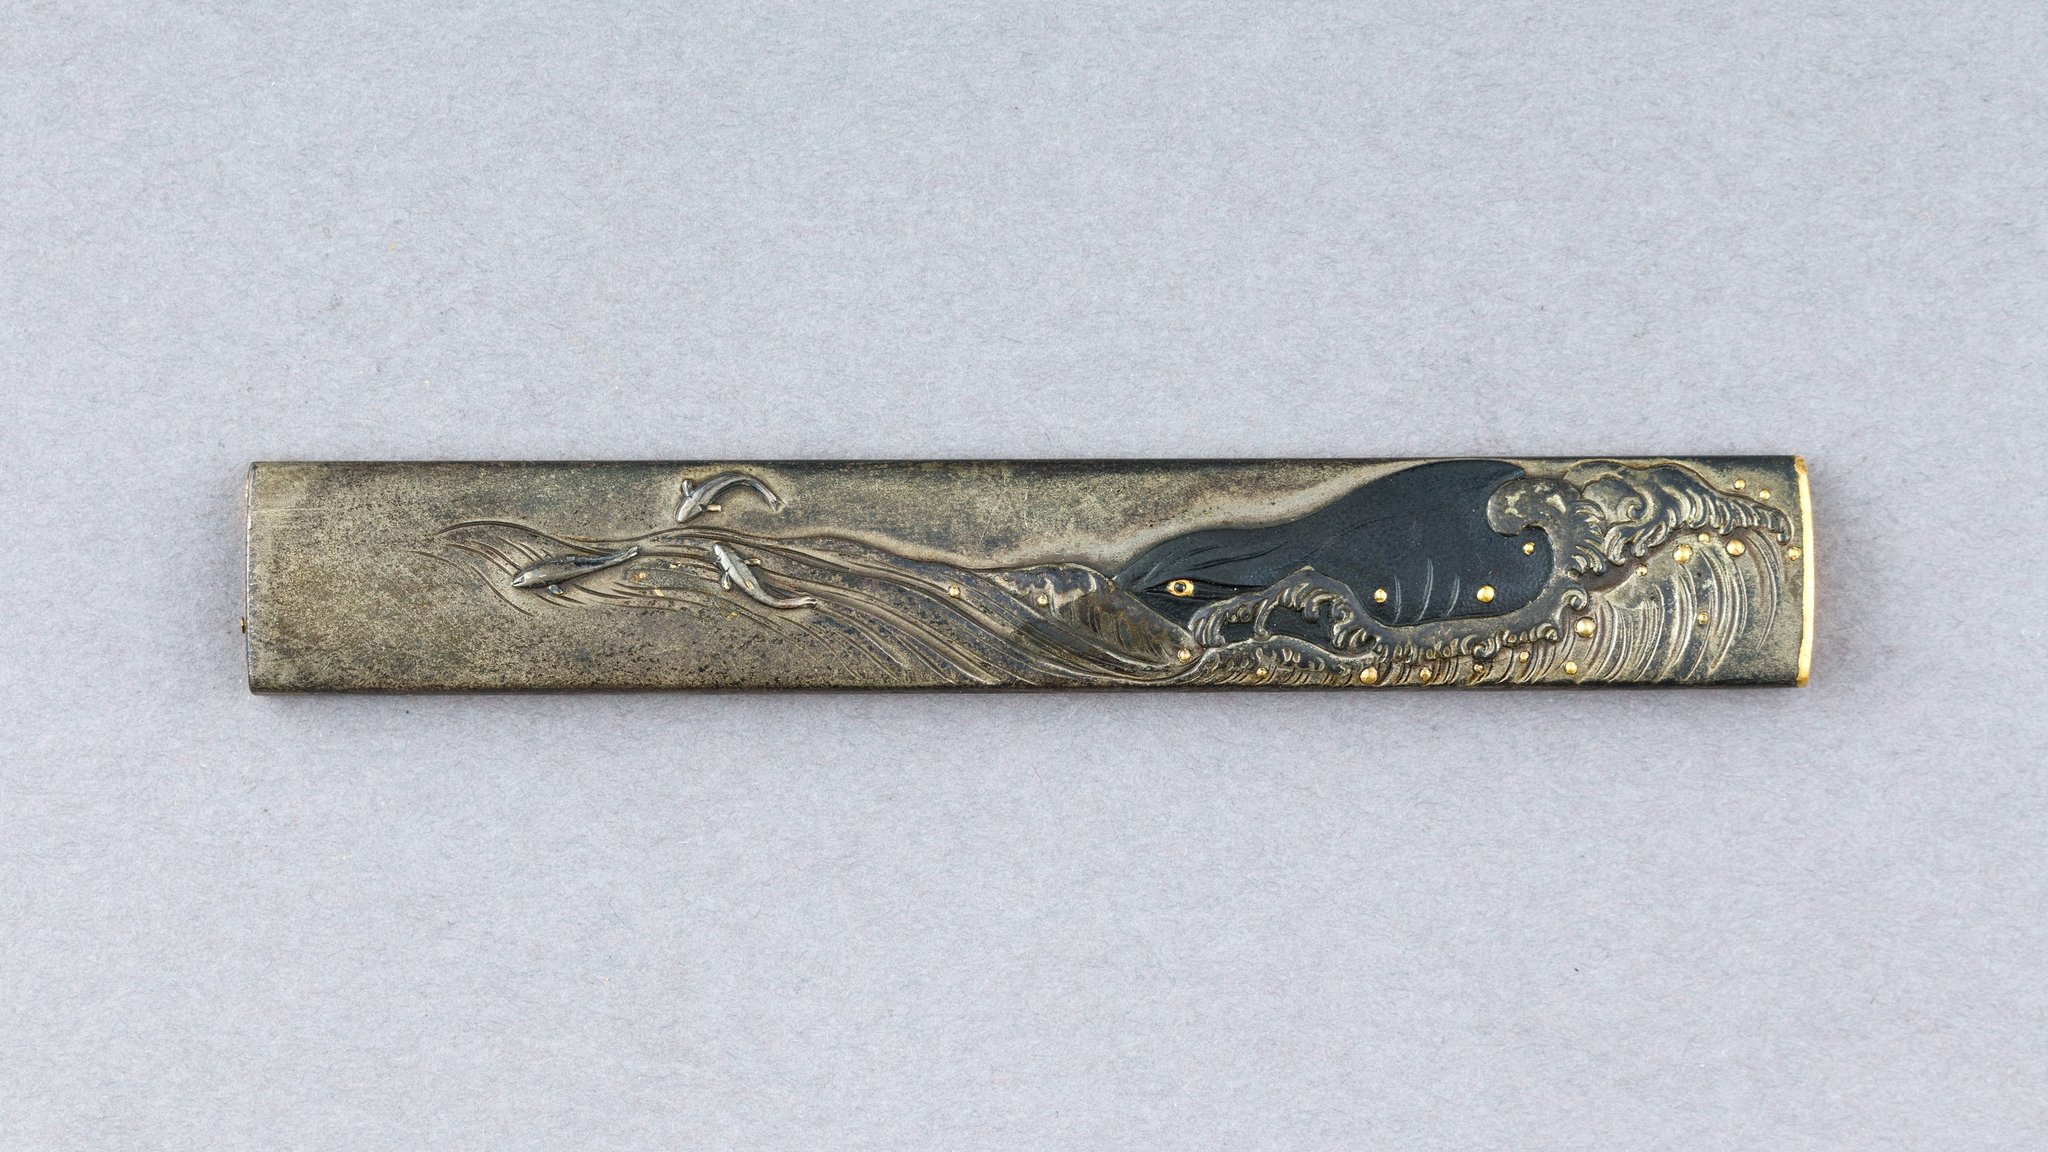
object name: knife handle kozuka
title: Knife Handle (Kozuka)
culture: japanese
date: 1615-1868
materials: gold alloy, silver alloy, gold, silver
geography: japan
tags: fish,waves